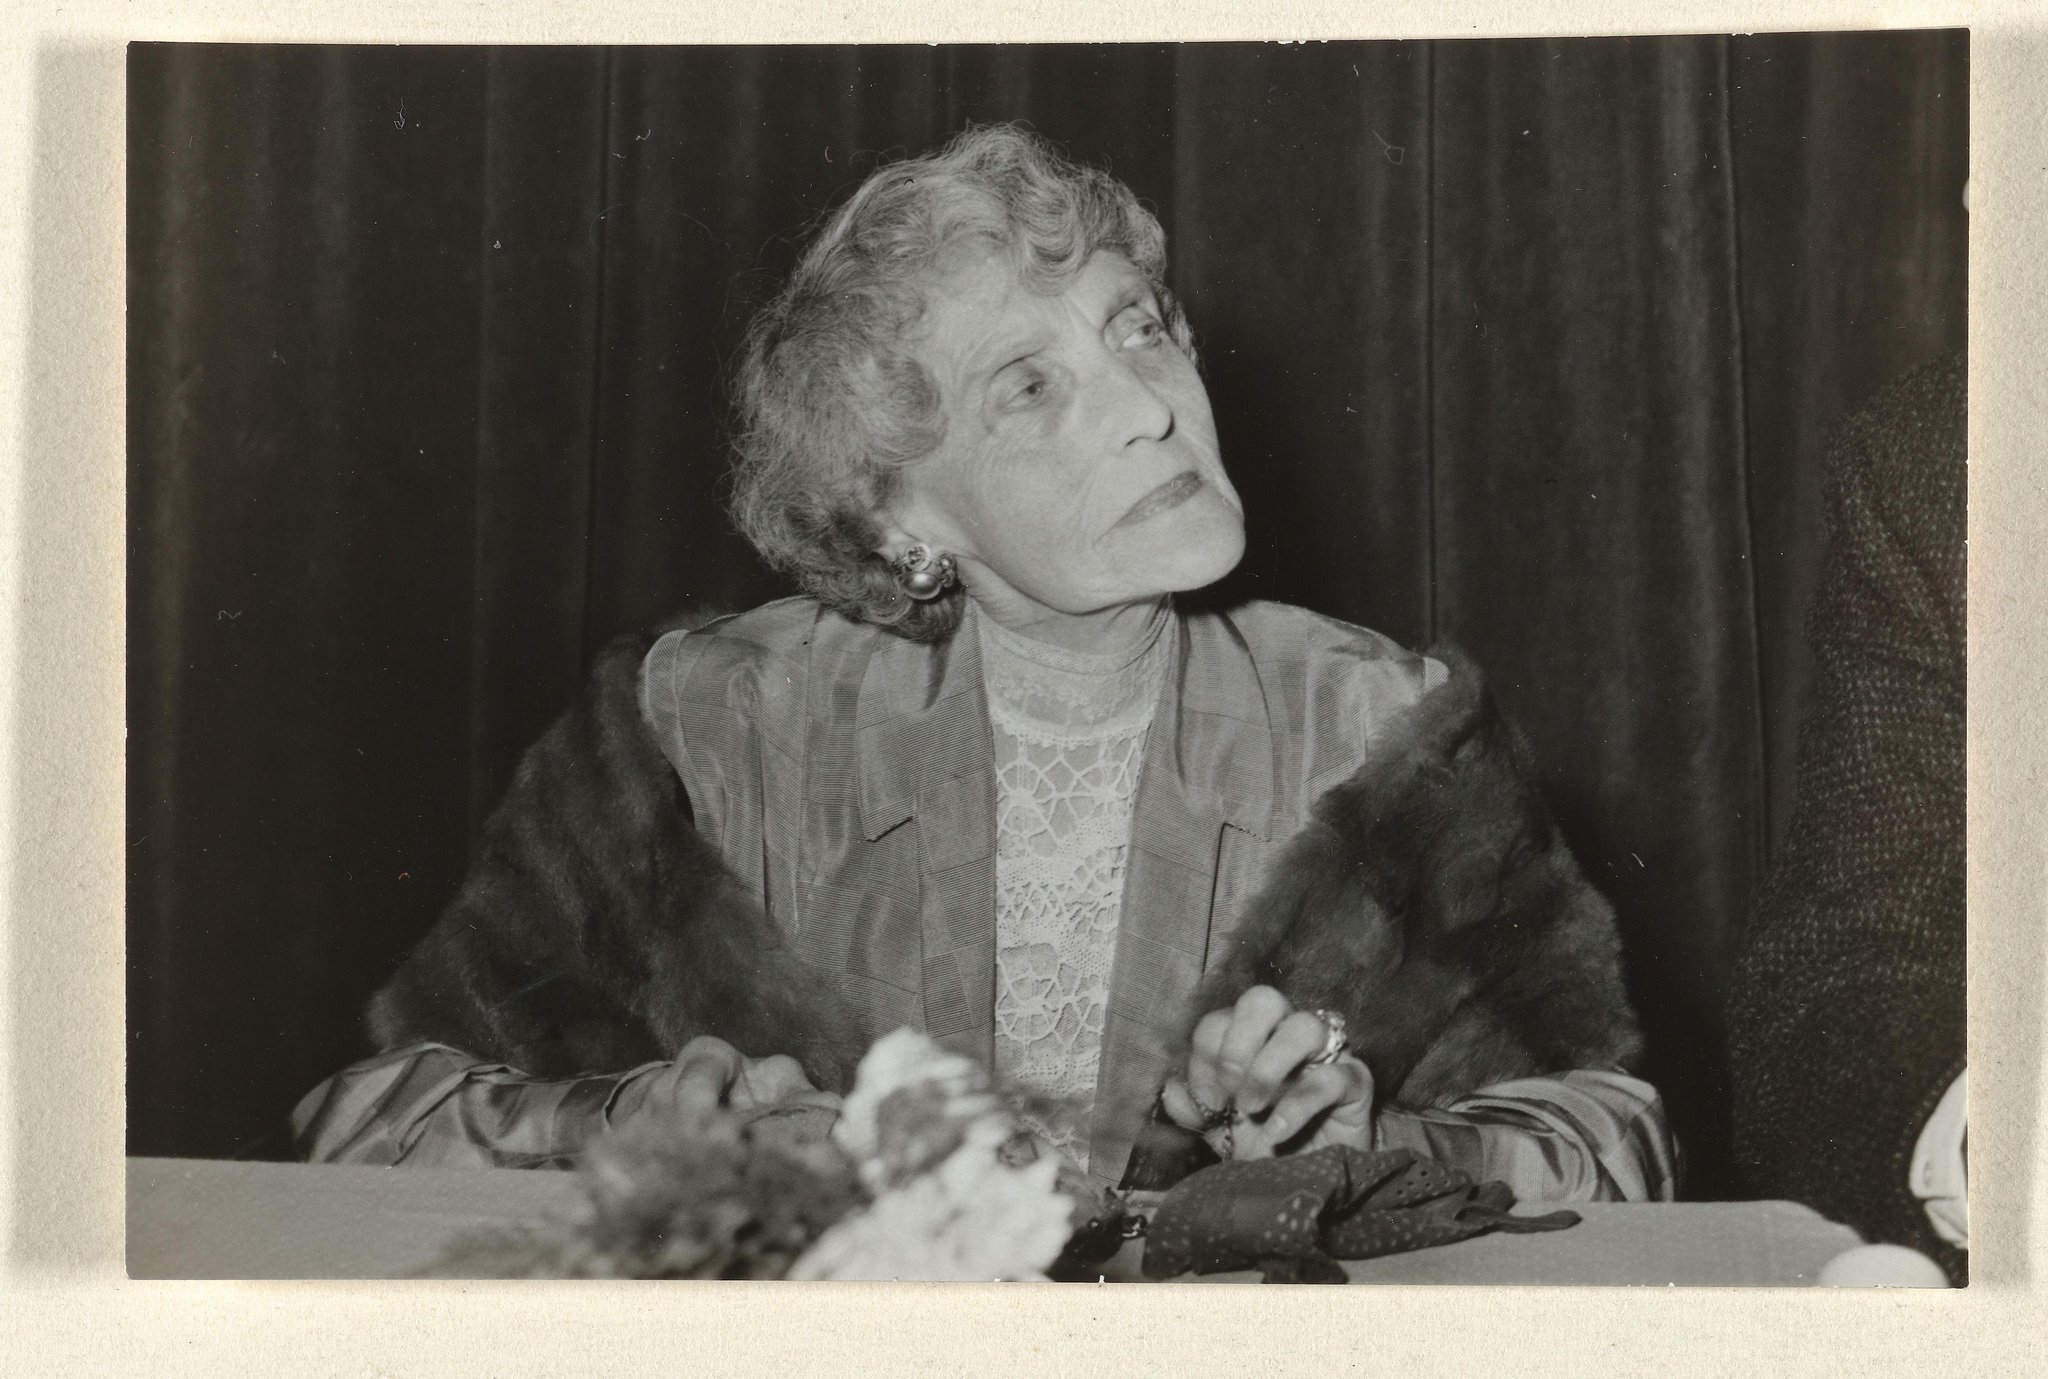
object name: photograph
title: Else Mauhs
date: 1900-1959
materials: photographic support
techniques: gelatin silver print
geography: amsterdam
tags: amsterdam, historical persons - bb - woman